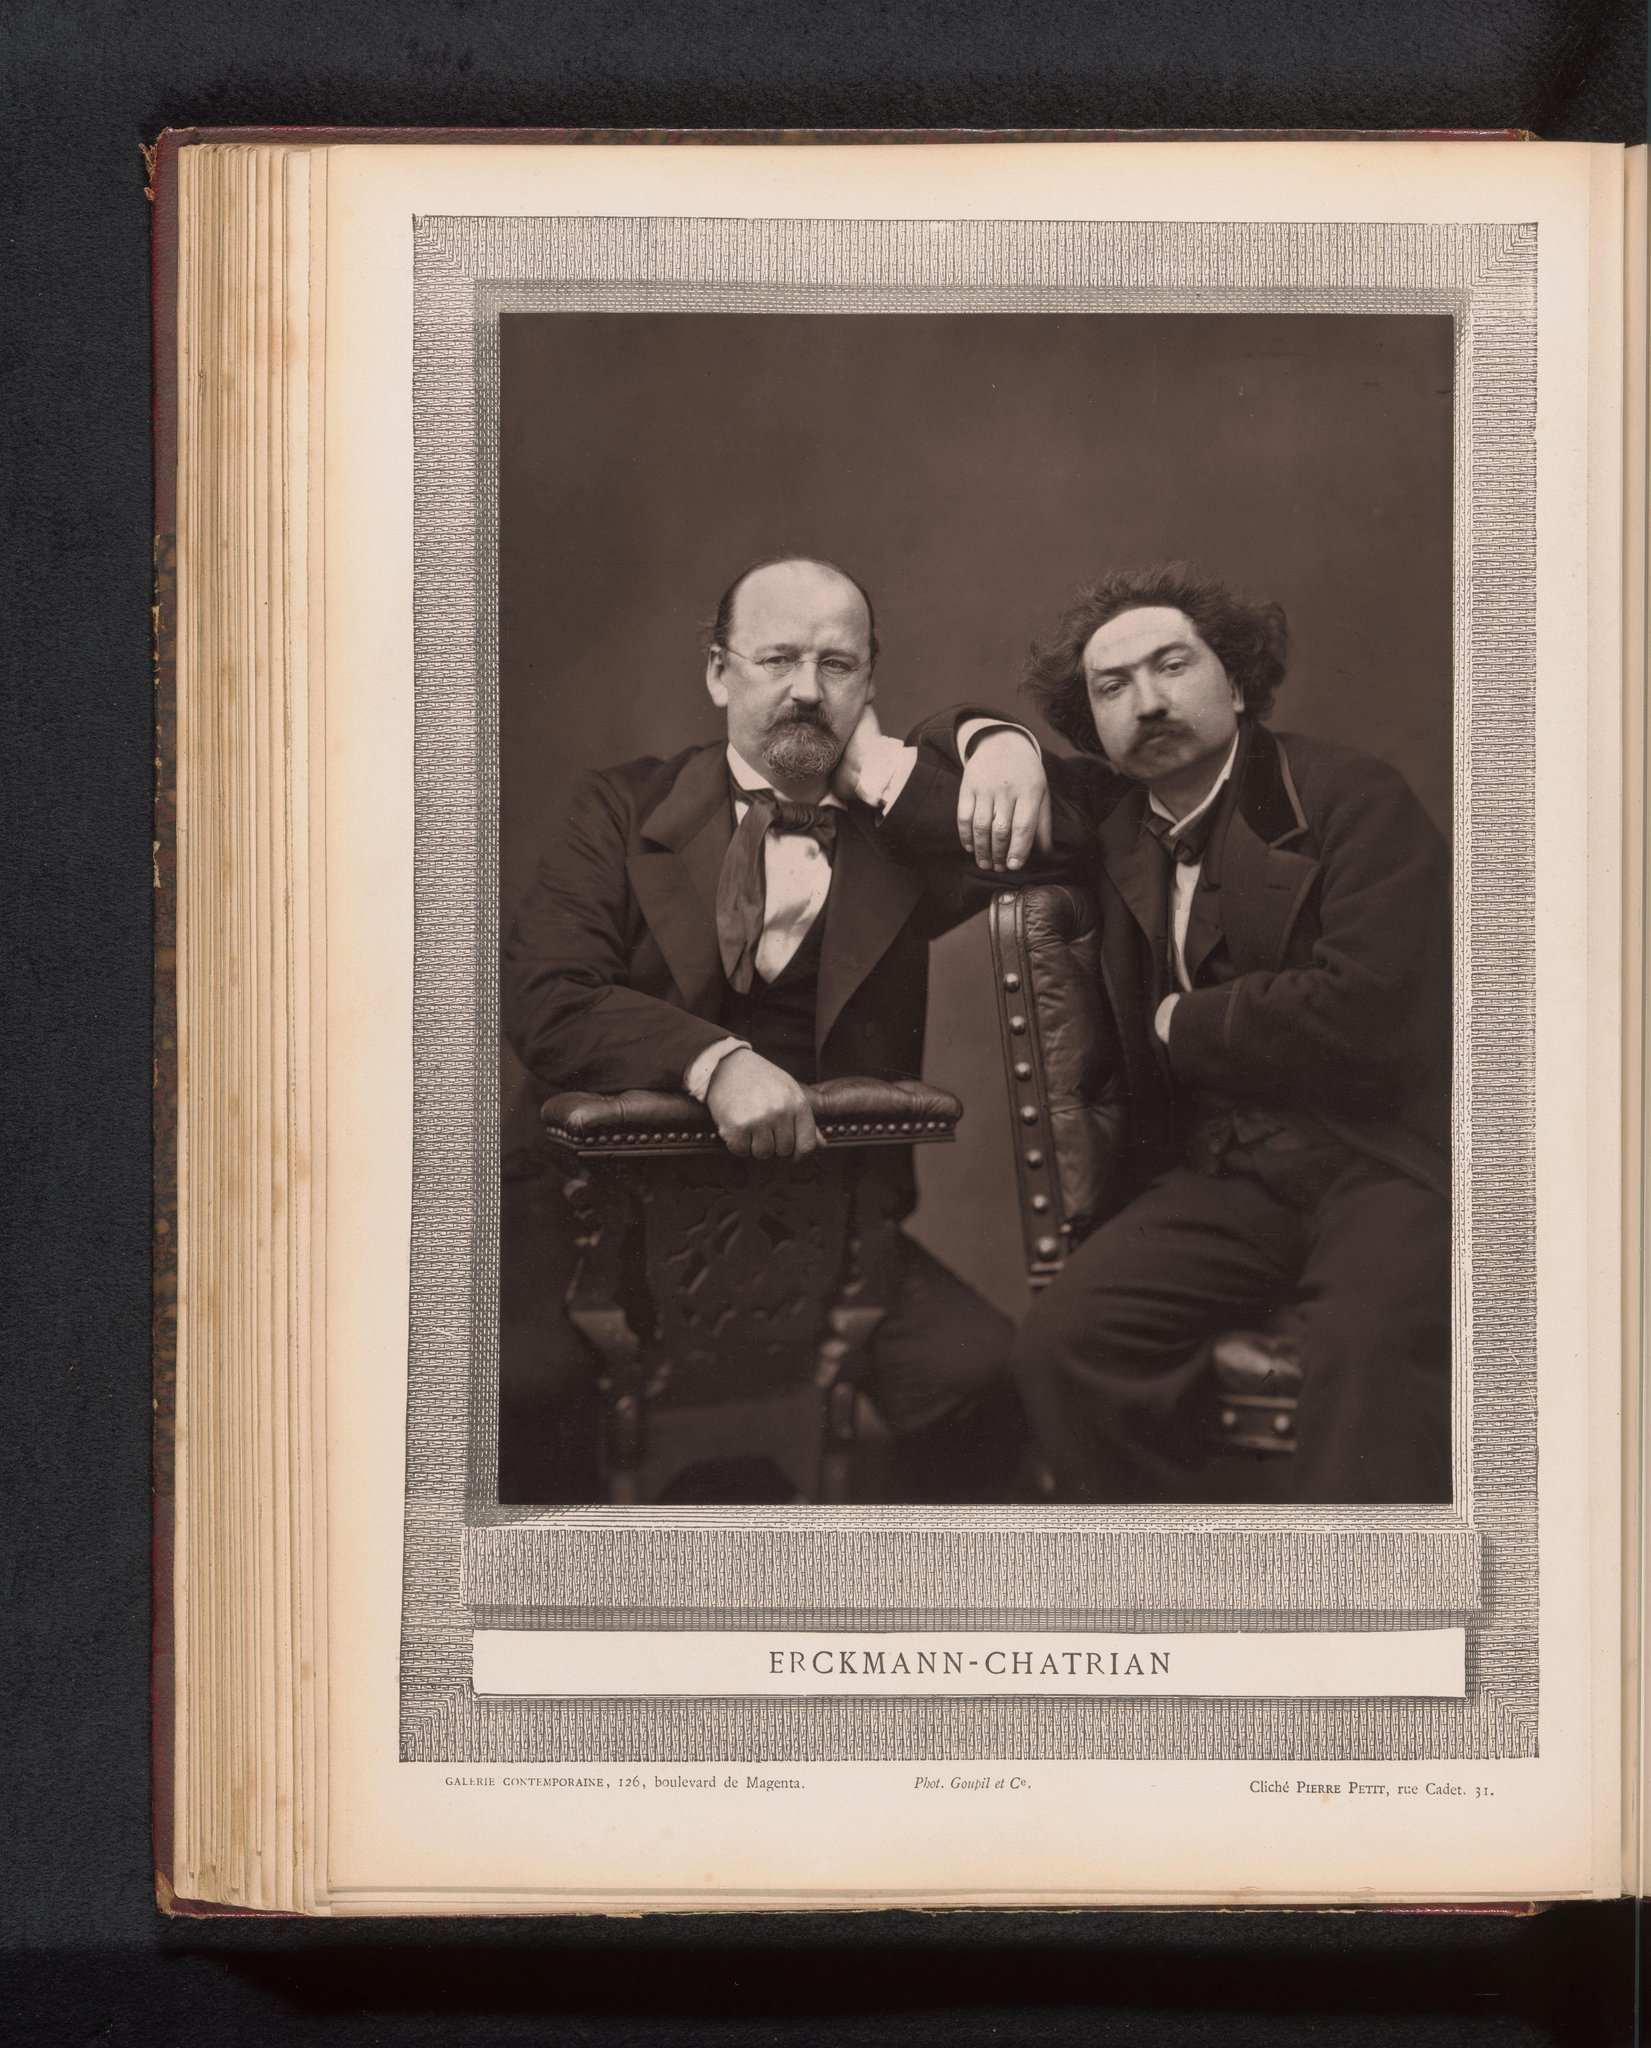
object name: photomechanical print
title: Erckmann-Chatrian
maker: pierre petit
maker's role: fotograaf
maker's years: 1832-1909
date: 1871-1876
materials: paper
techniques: woodburytype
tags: adult man, historical persons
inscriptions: inscription: ‘Galerie Contemporaine, 126, boulevard de Magenta.’